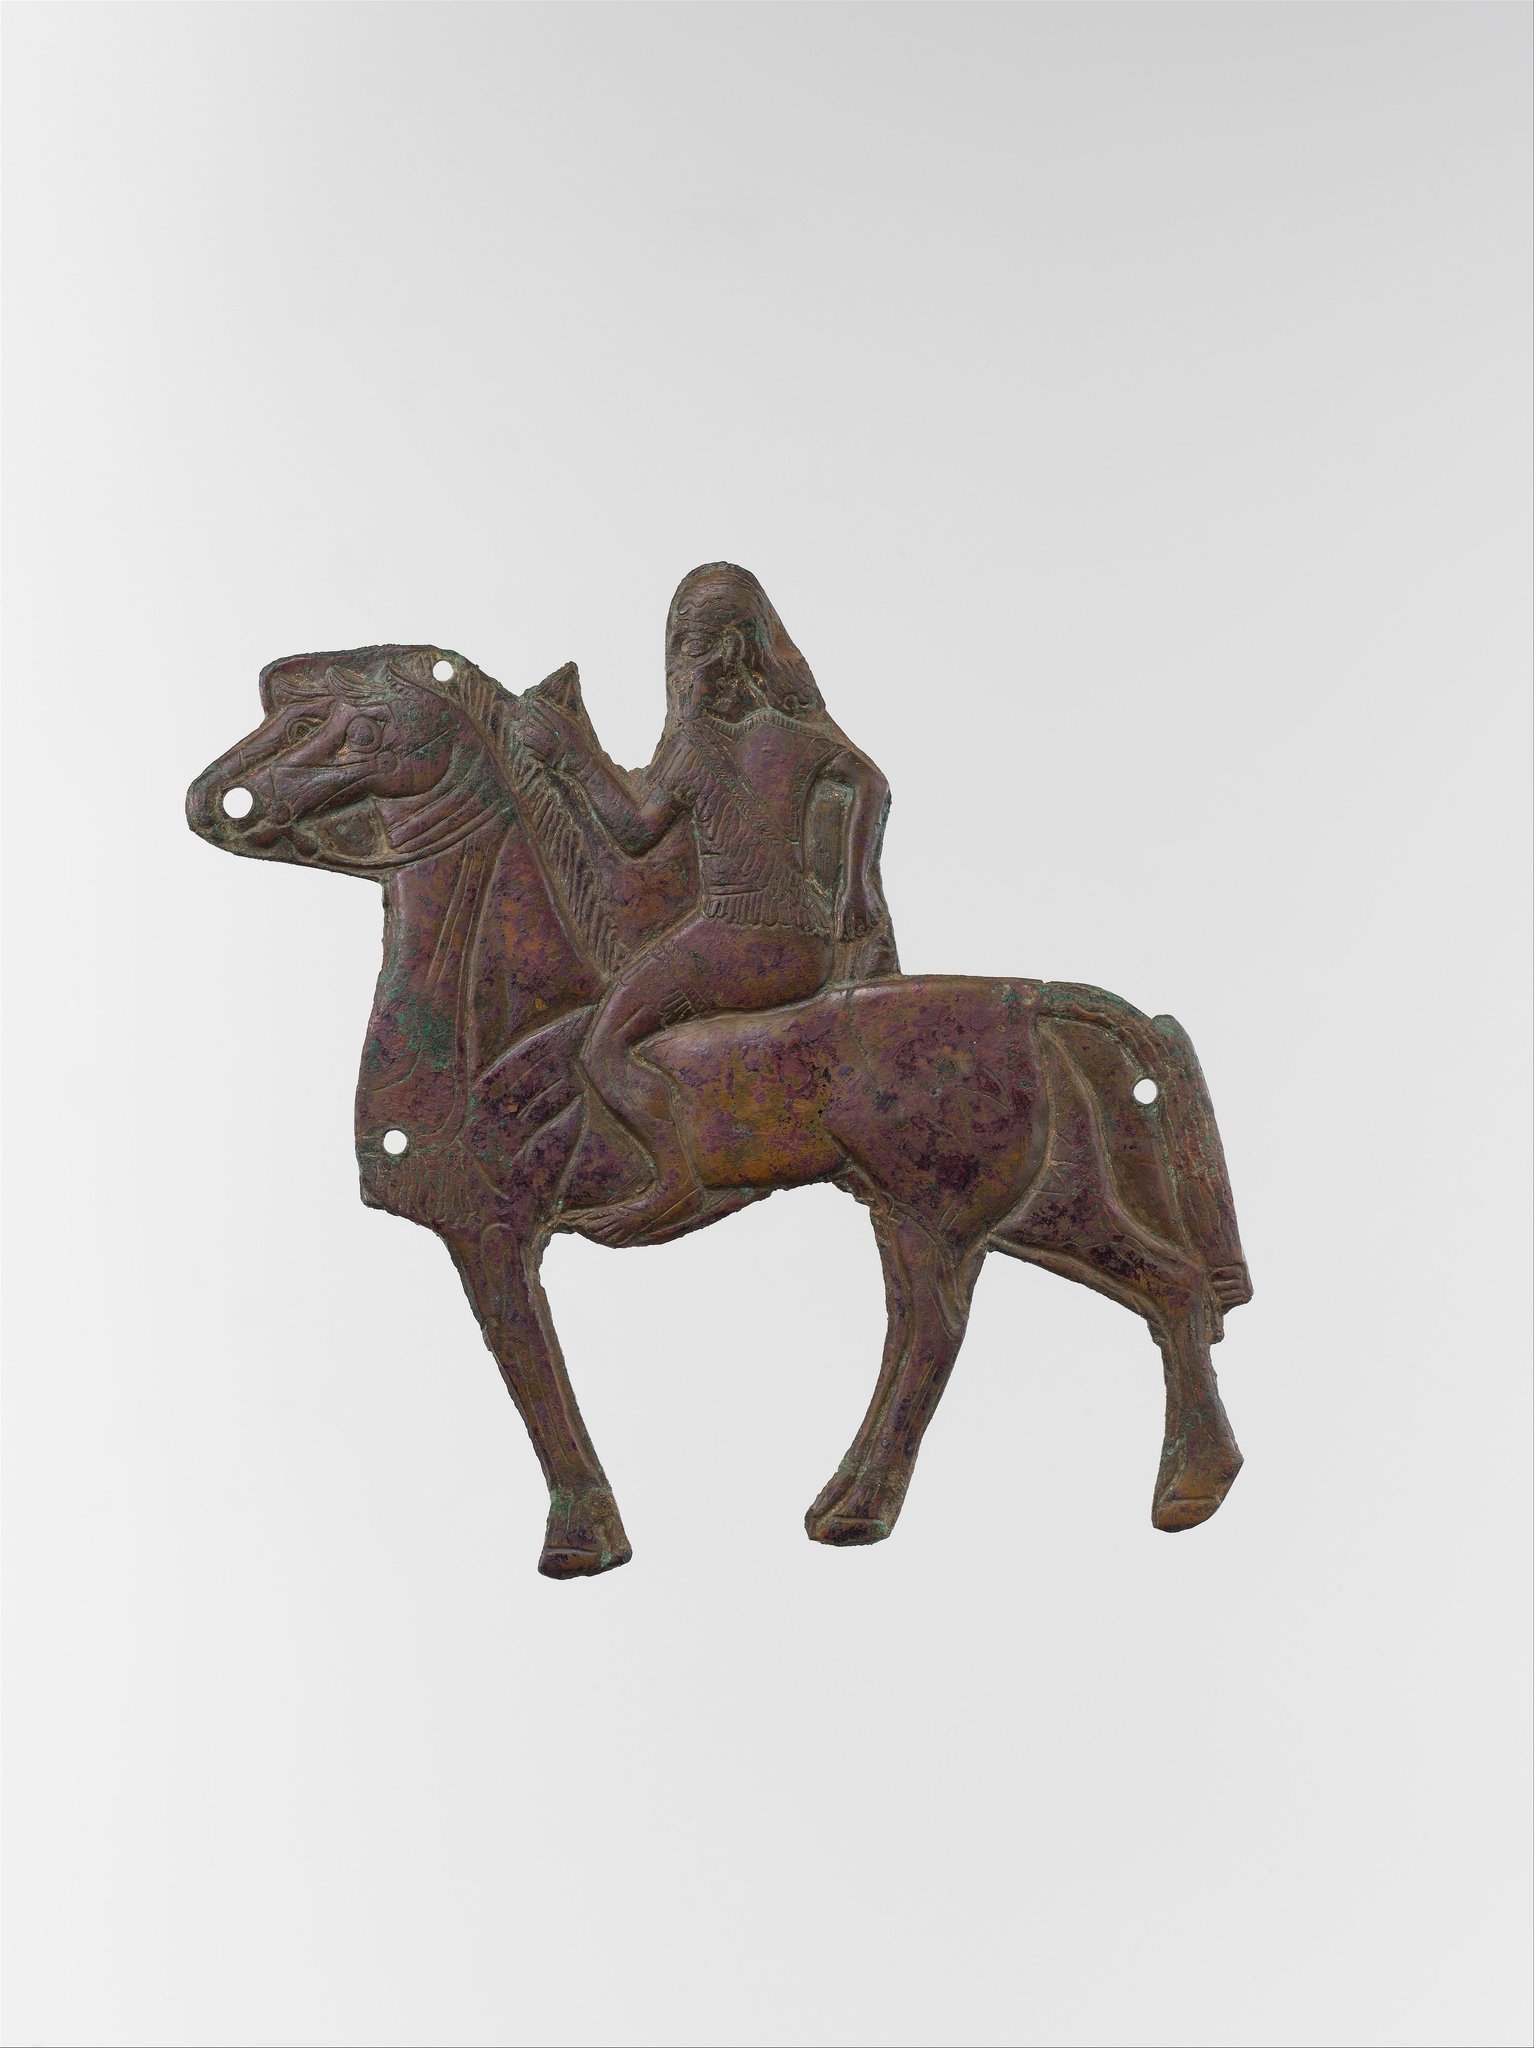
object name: relief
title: Plaque depicting a horse and rider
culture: assyrian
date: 883-859 BCE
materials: bronze, gold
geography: mesopotamia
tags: men,horses